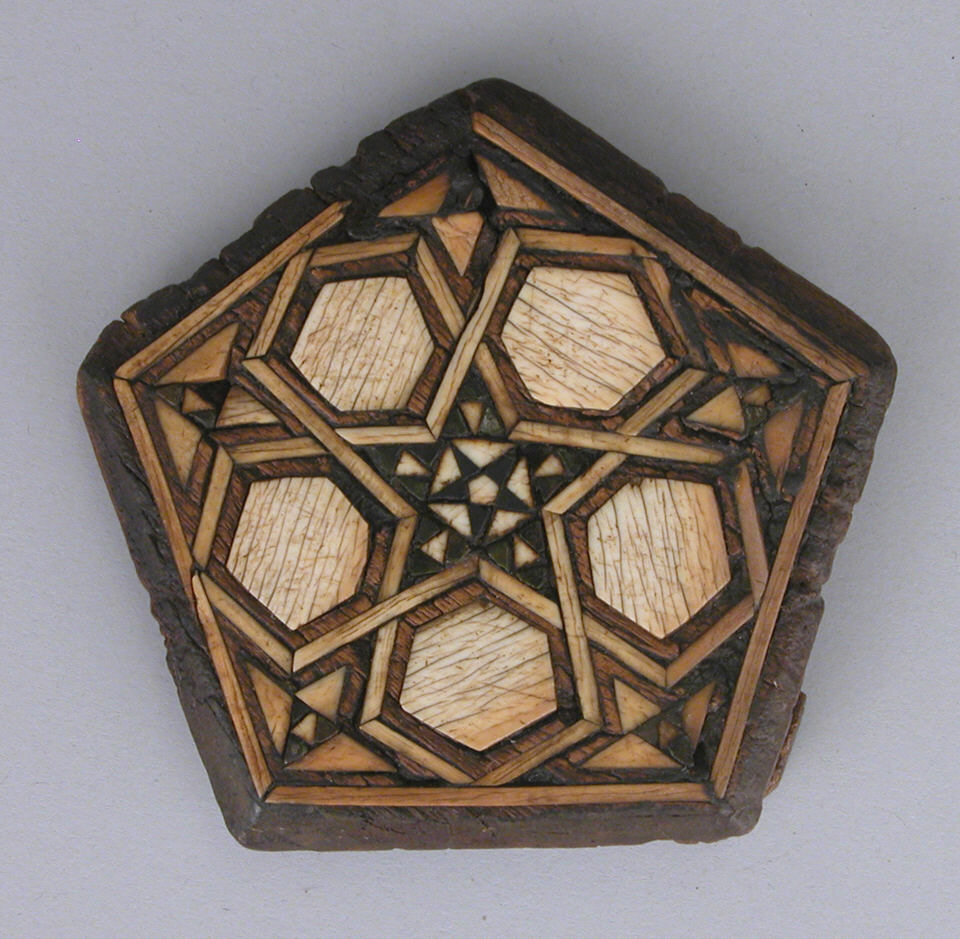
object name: panel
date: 1467-1500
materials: ivory, wood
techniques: carving, inlay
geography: egypt